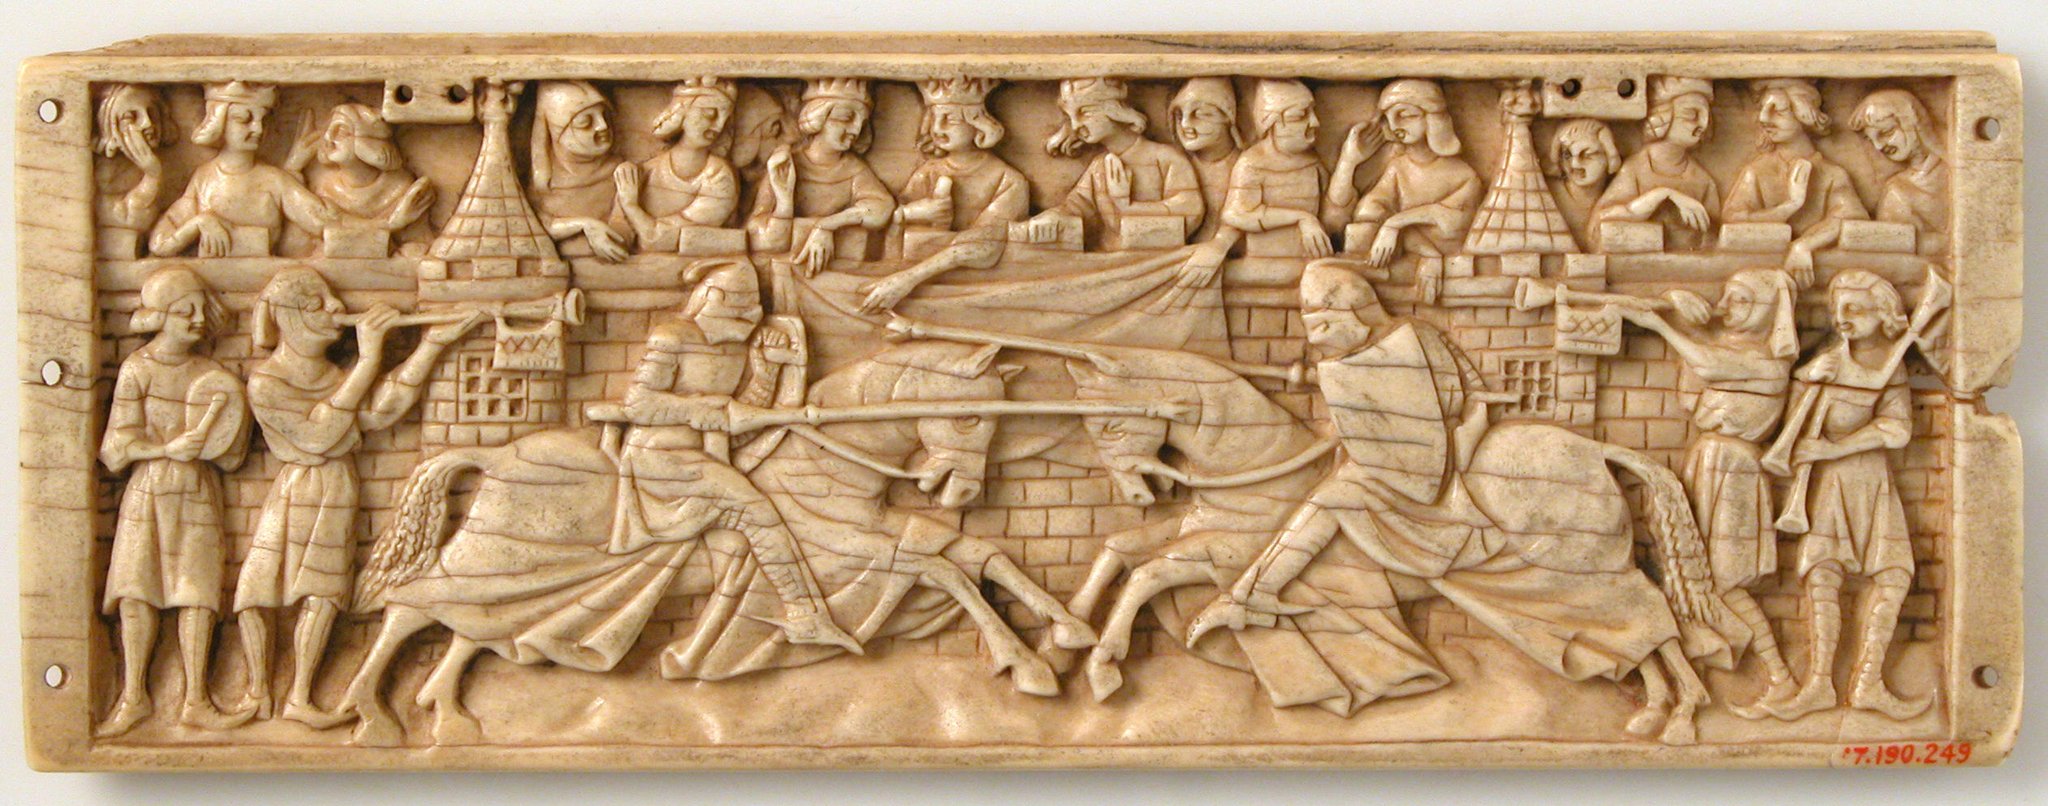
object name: panel, from a box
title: Panel from a Box with Scene of Jousting Knights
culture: european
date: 1801-1900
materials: ivory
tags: musical instruments,weapons,men